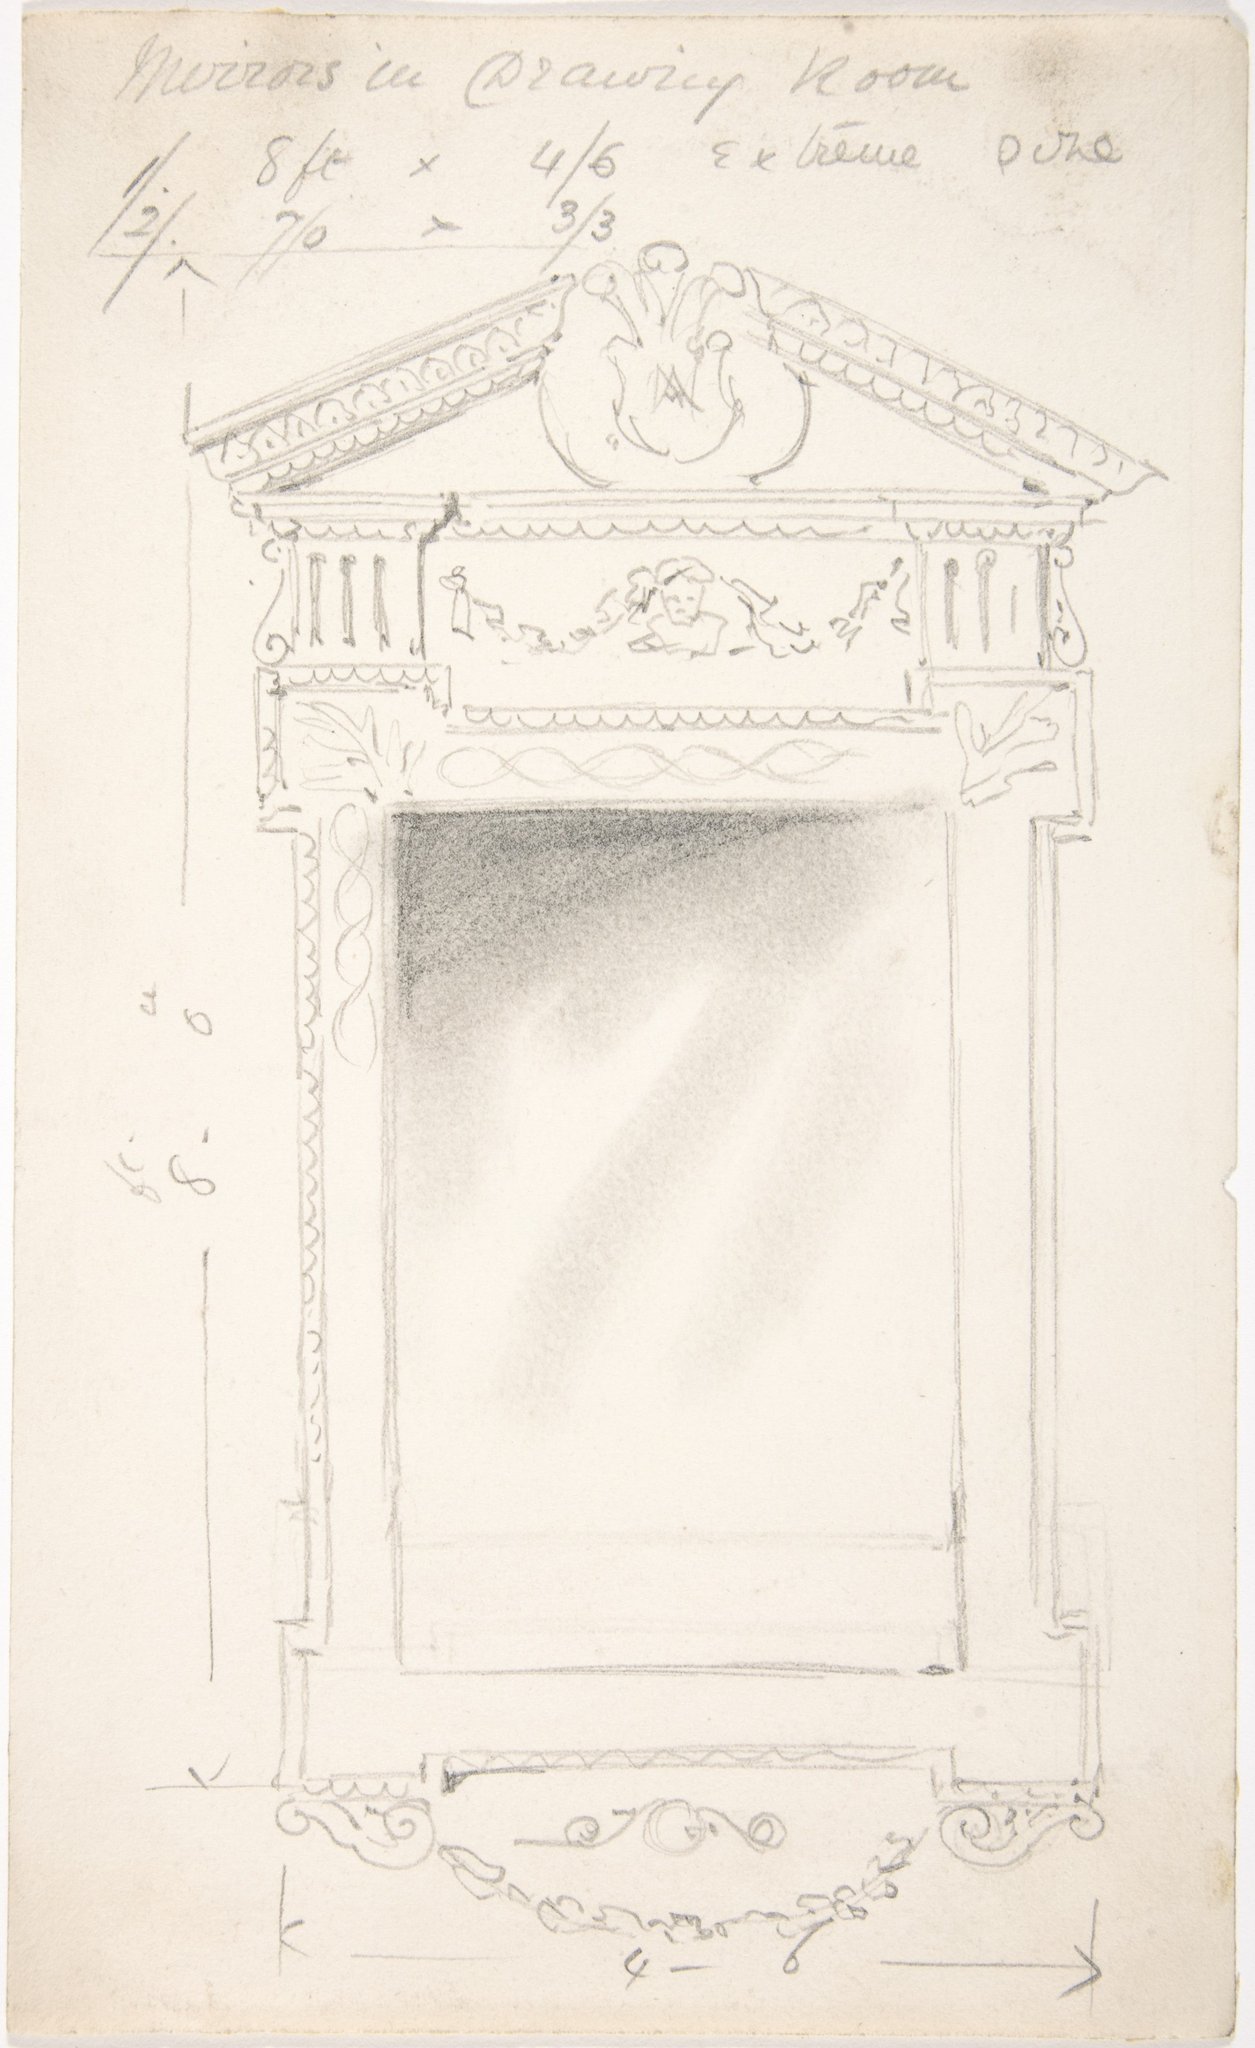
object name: drawing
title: Design for a Drawing Room Mirror, for 11 Princes Gate, London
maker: anonymous, british, 19th century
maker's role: artist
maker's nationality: british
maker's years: 1800-1900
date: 1801-1900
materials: graphite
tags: mirrors